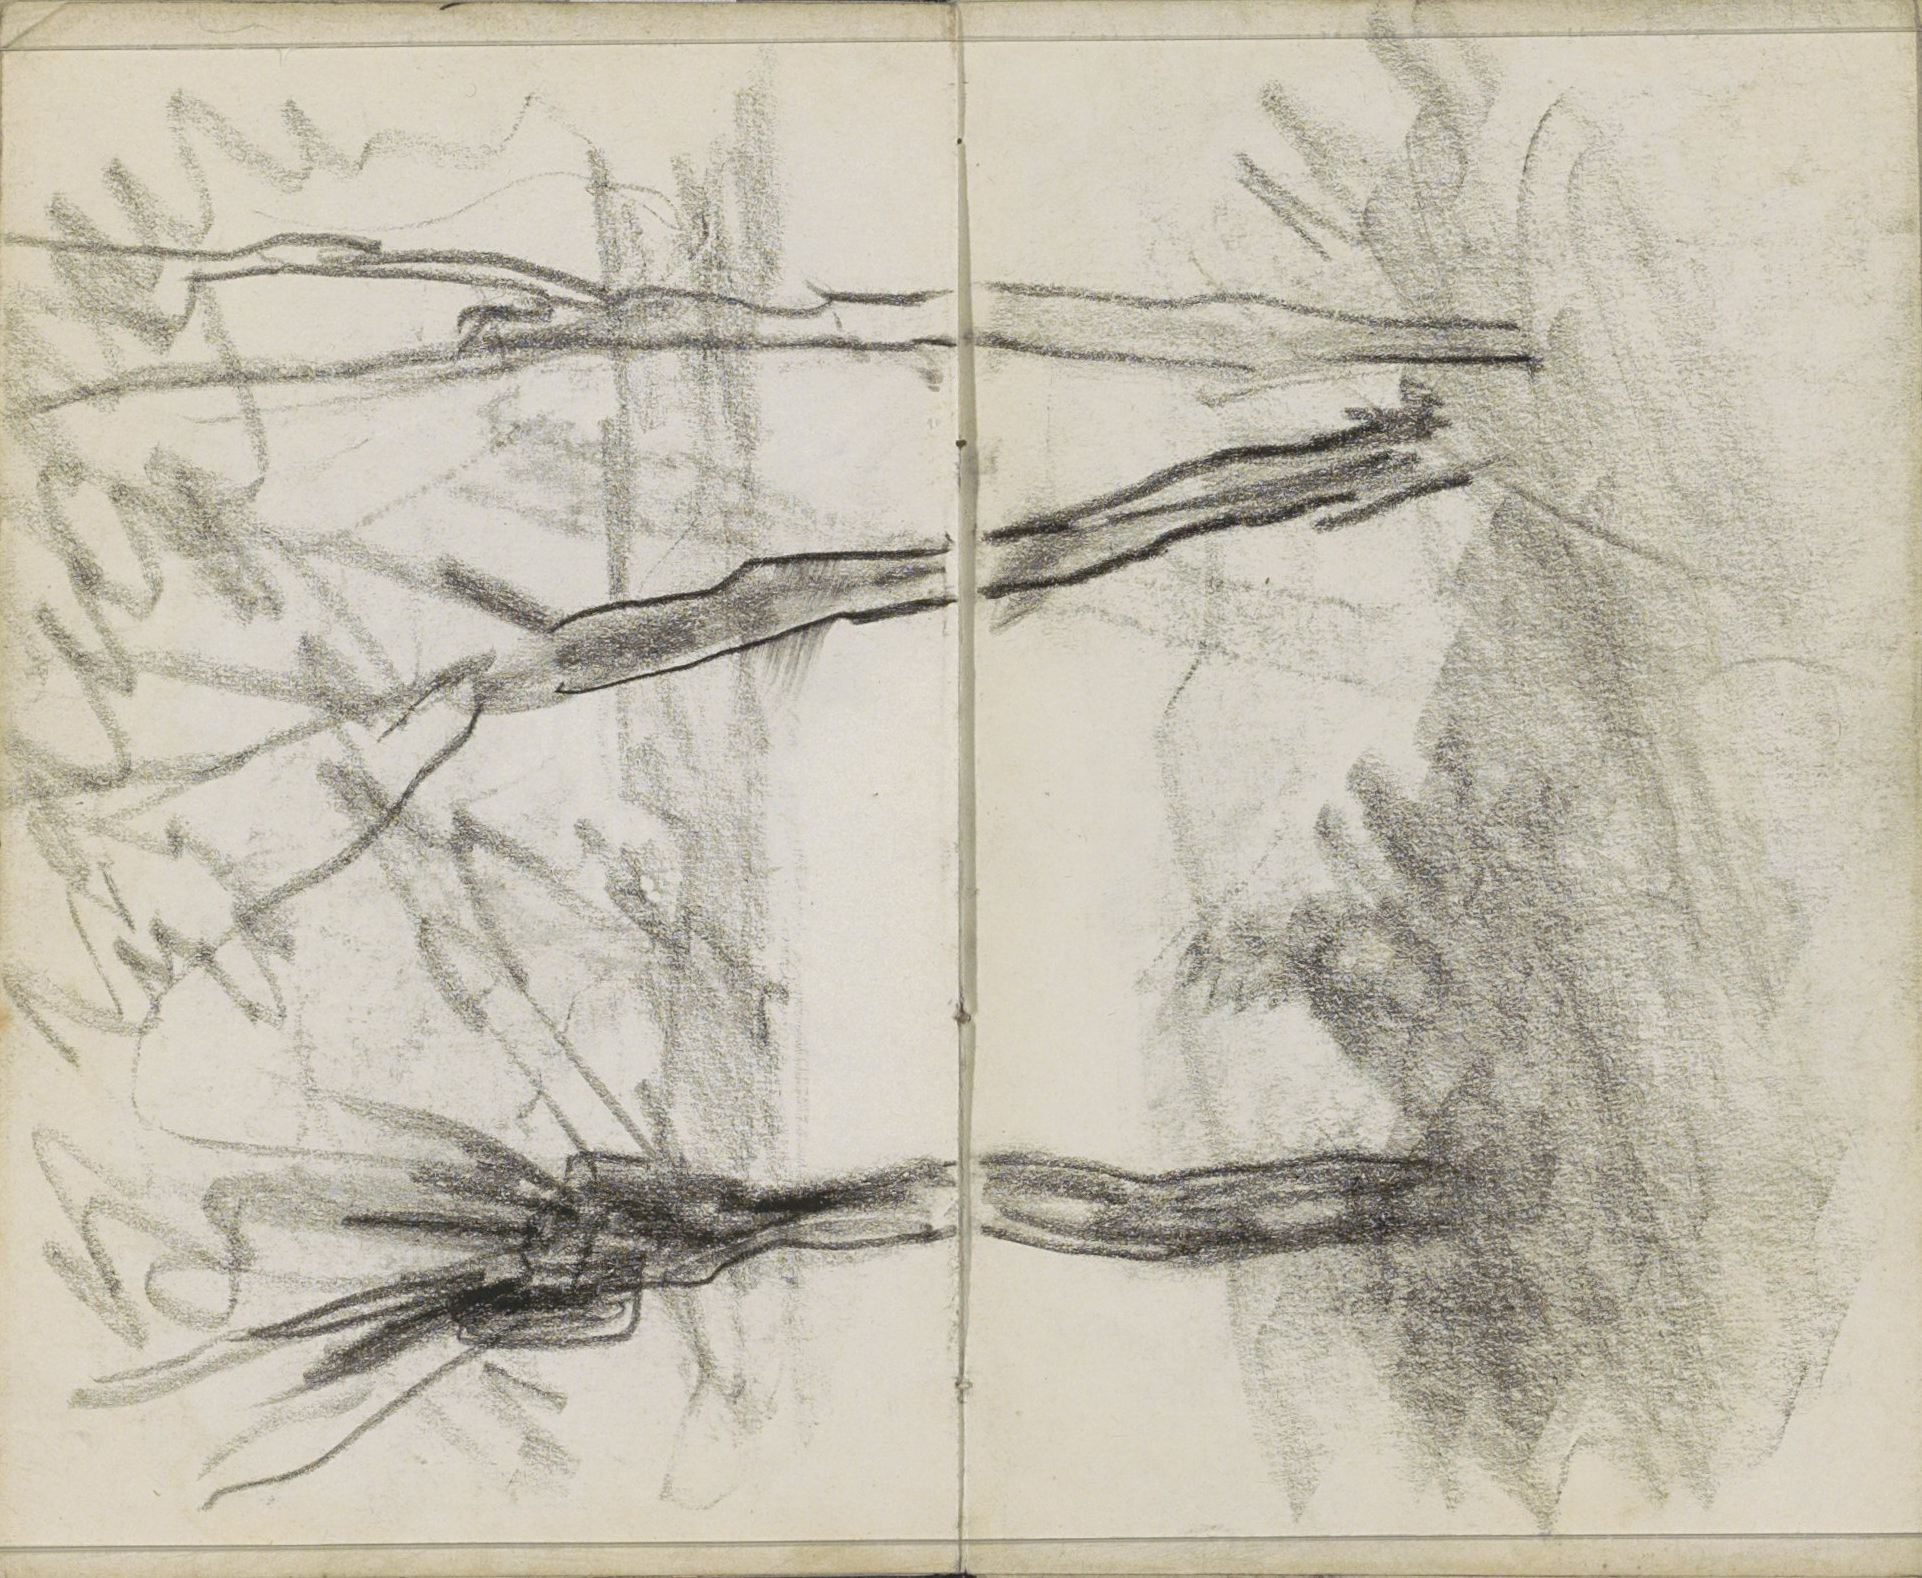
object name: sketchbook leaf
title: Bomen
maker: anton mauve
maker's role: draughtsman, painter, print maker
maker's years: 1838-1888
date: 1848-1888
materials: chalk, paper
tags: trees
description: Blad 6 verso en 7 recto uit een schetsboek met 53 bladen.